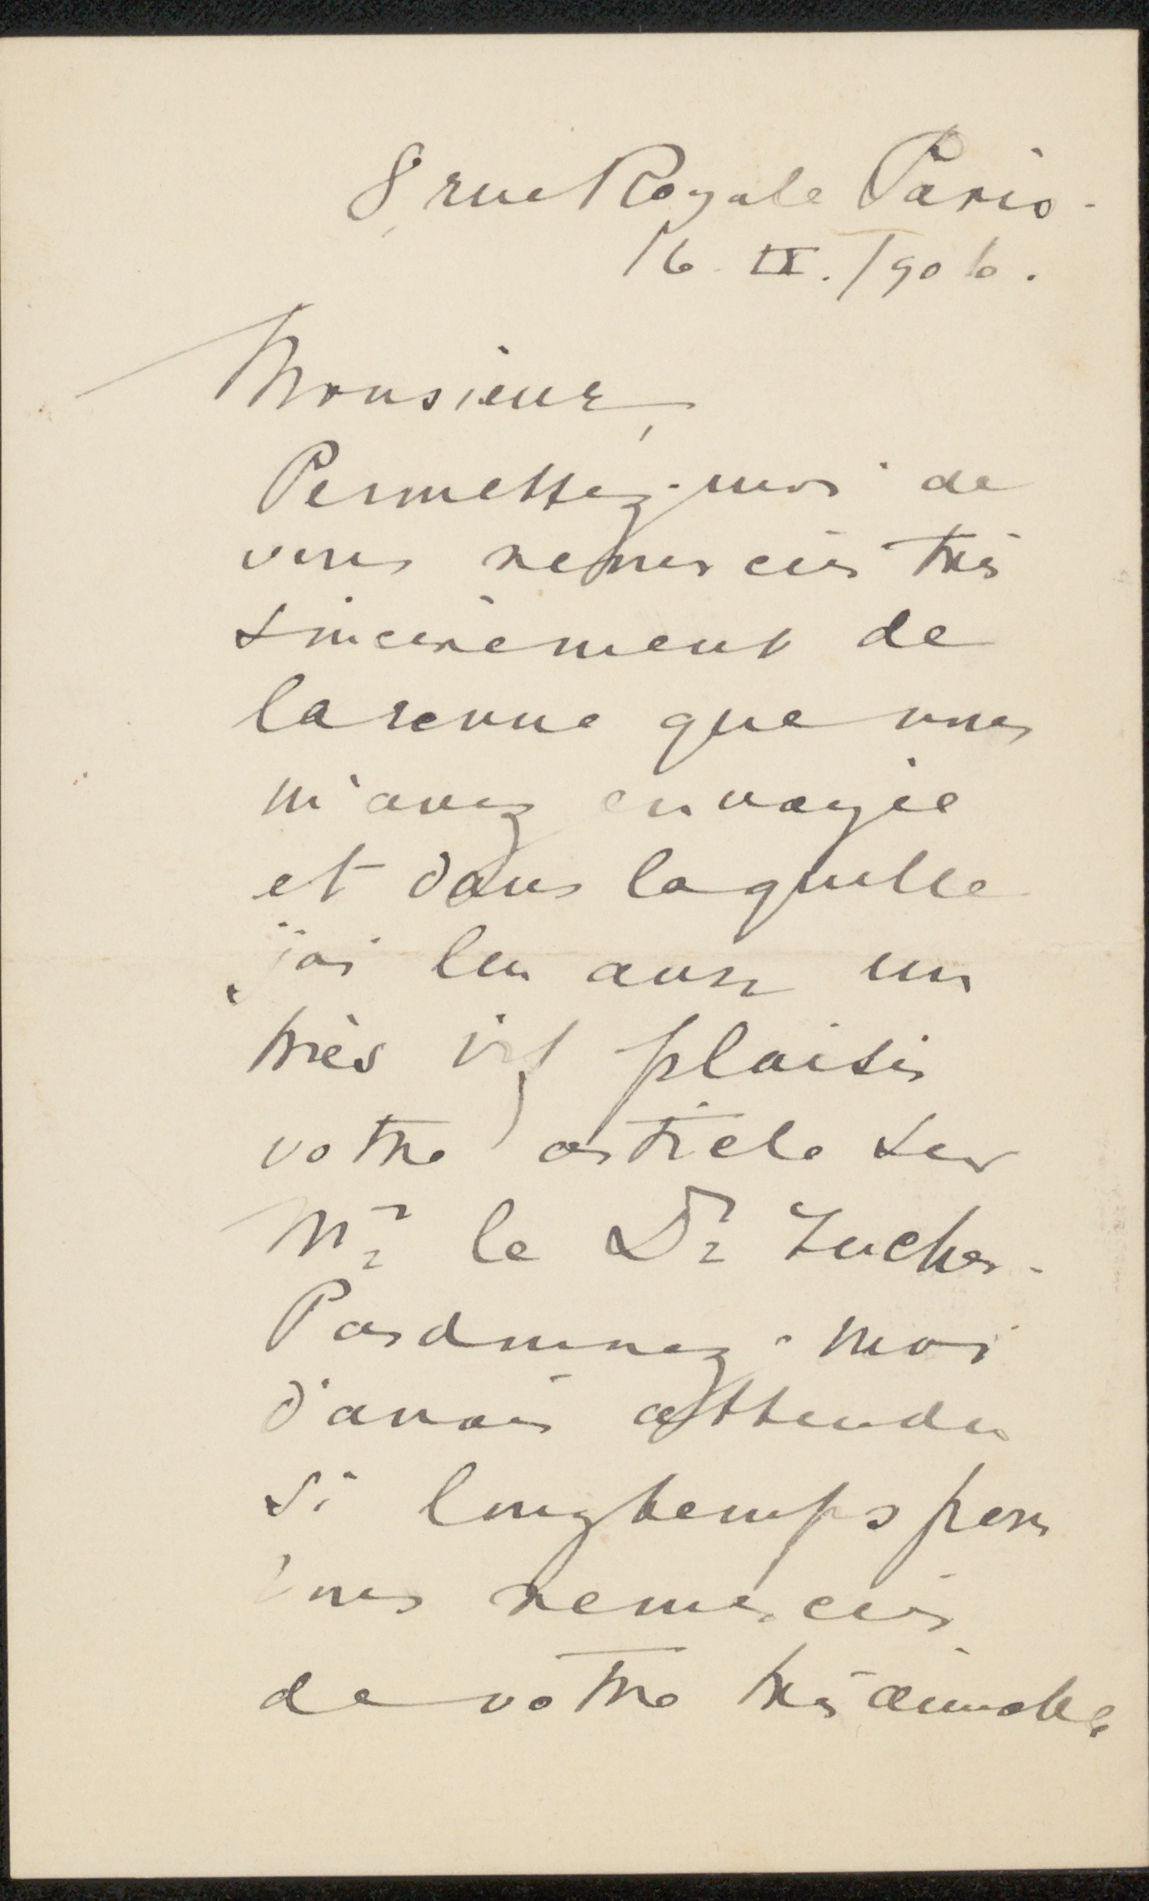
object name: letter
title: Brief aan Philip Zilcken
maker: minnie plummer scalar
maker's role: zangeres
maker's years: 1869-1944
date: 1906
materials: ink, paper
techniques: pen, writing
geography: paris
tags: painter, draughtsman, philip zilcken, printed matter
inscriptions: collector's mark: ‘RPK’, watermark